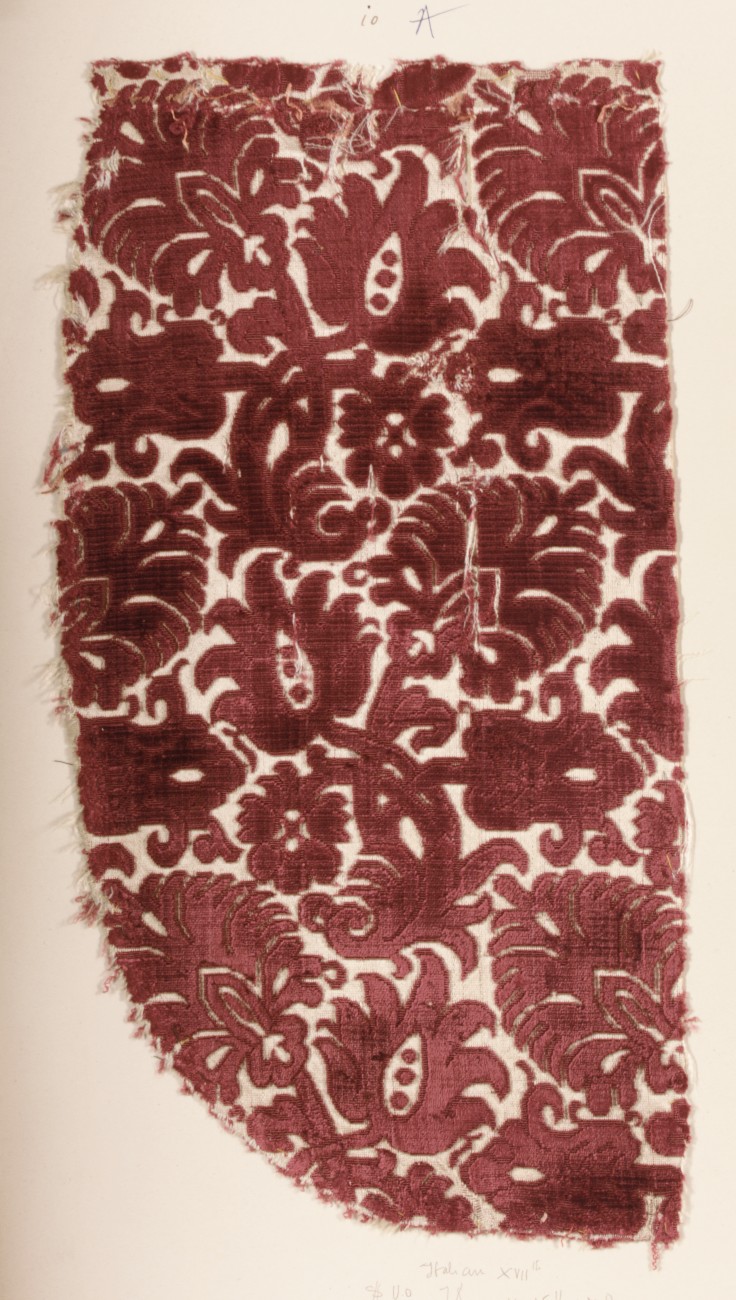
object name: fragment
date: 1601-1700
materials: silk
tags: flowers,leaves